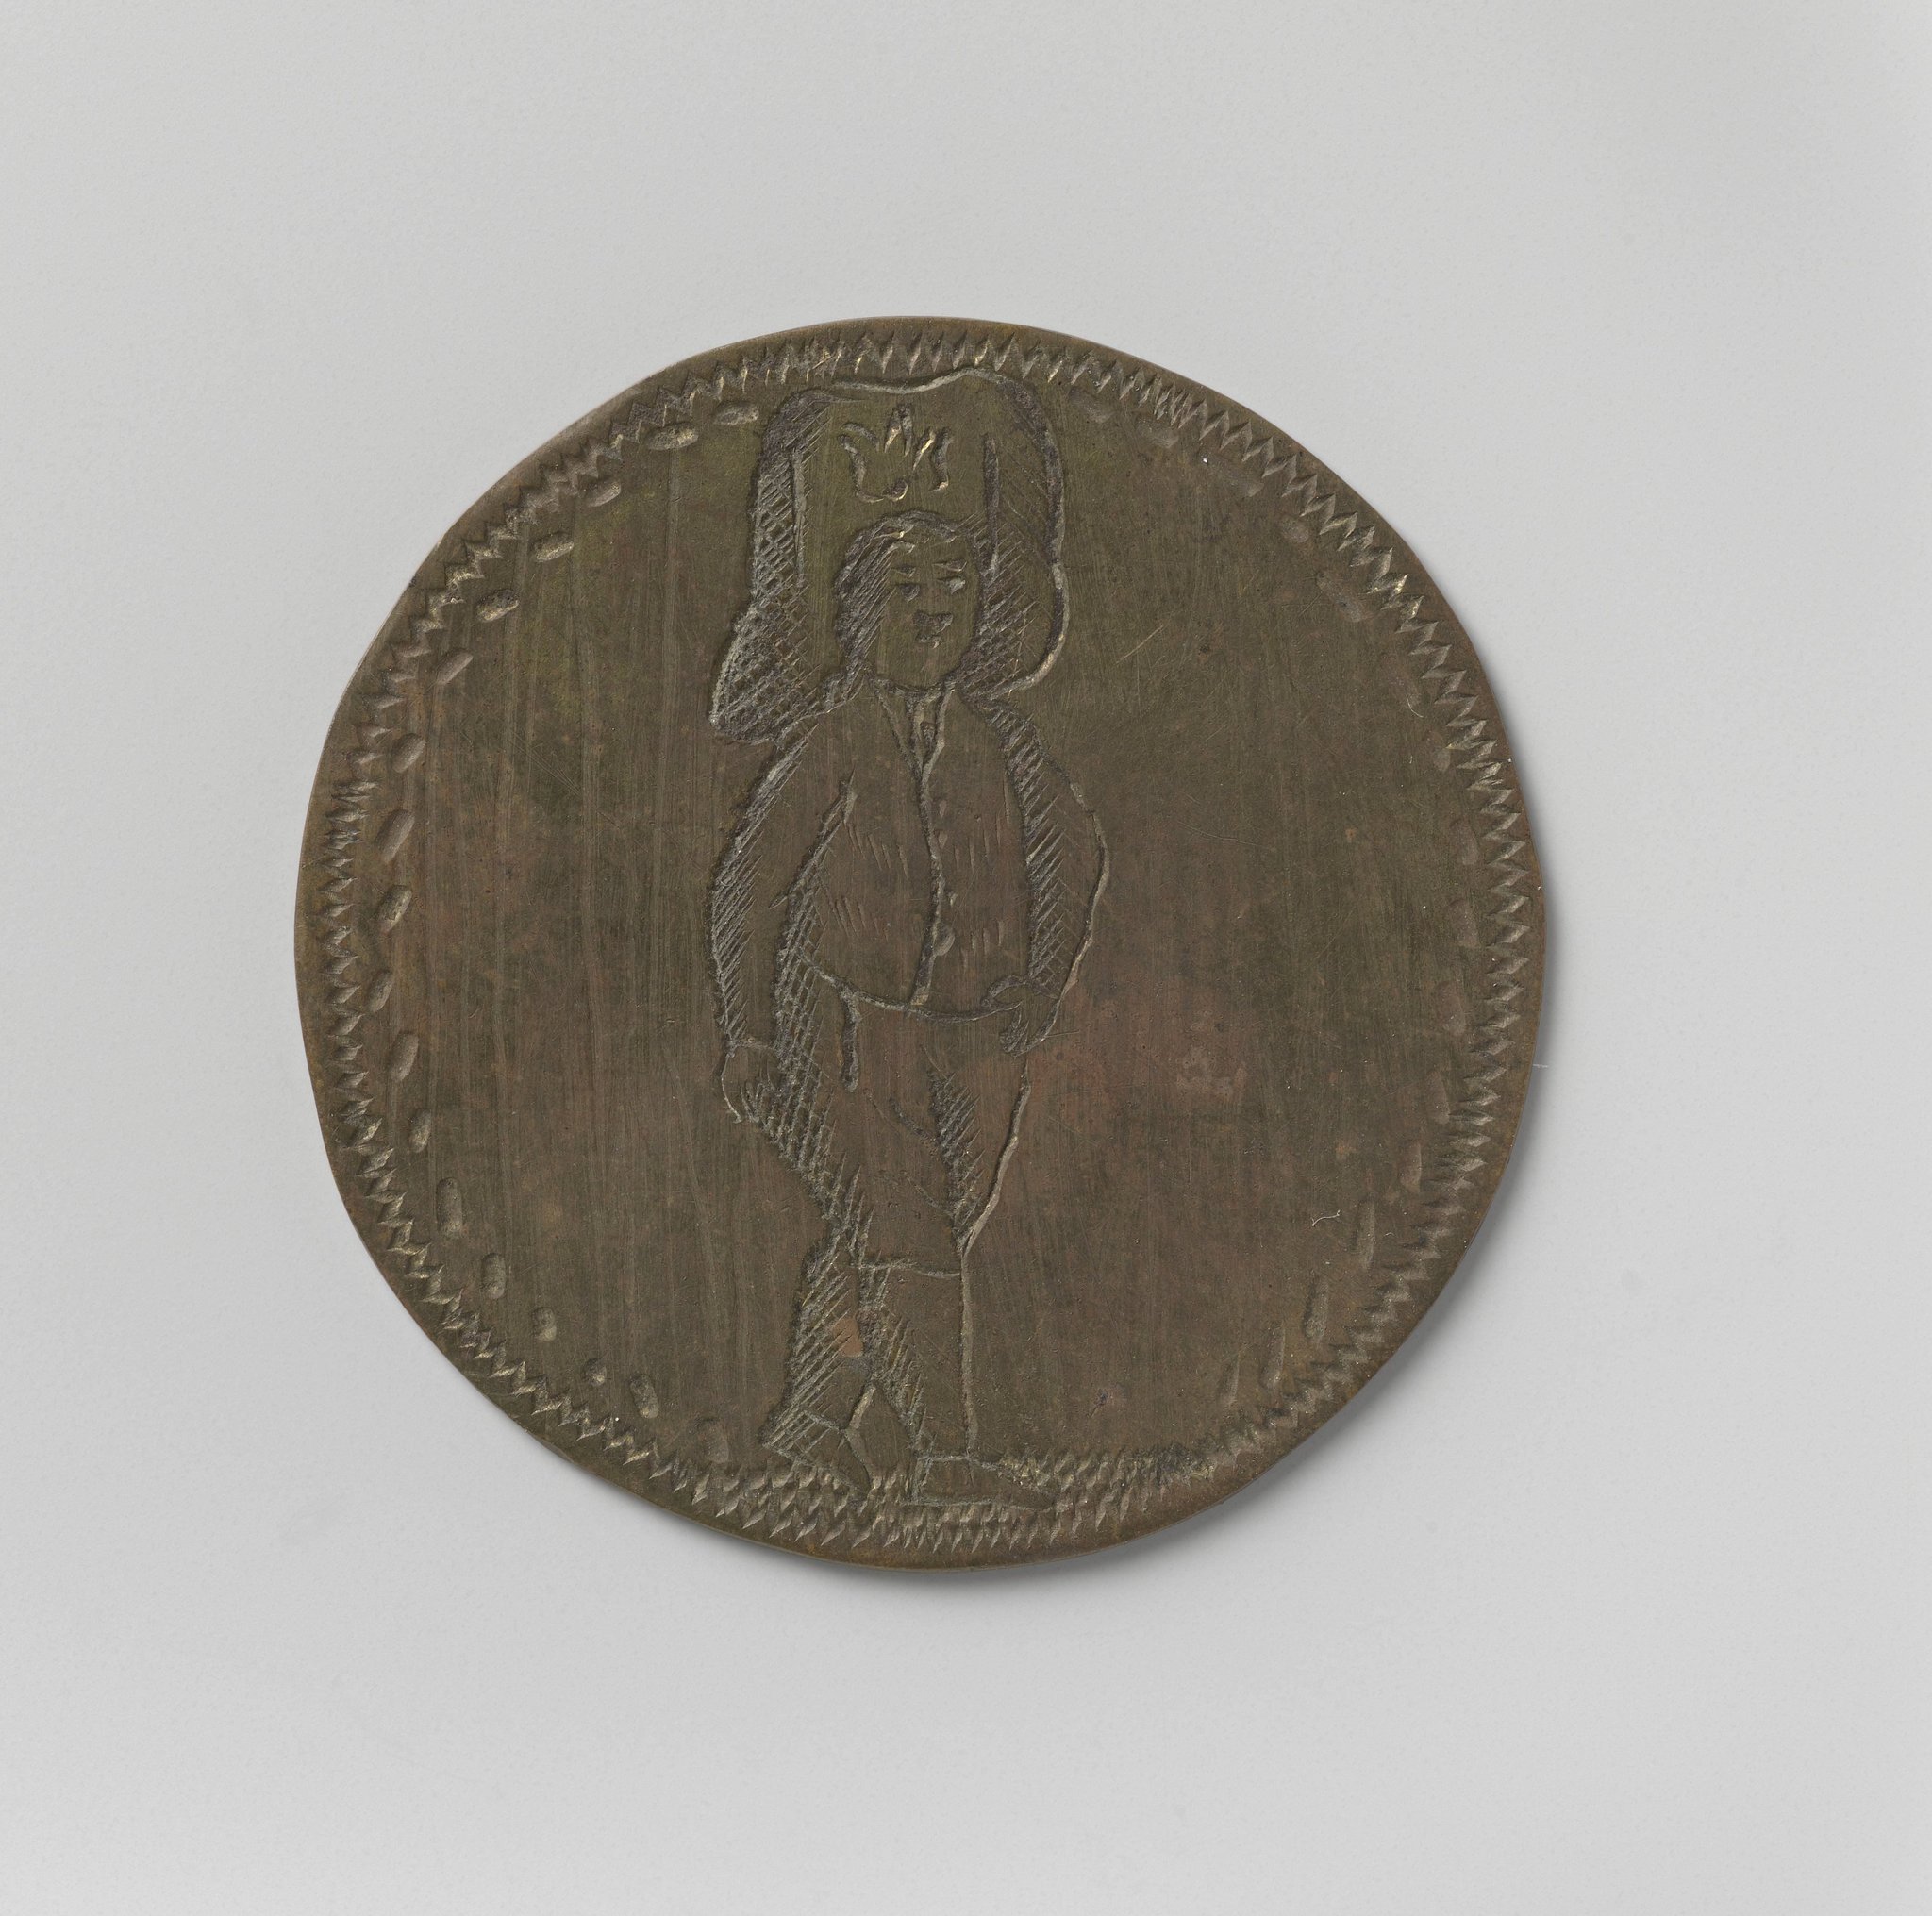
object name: medal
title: Korendragers- en -stortersgilde van Amsterdam, gildepenning van Jurrien Sigesmund Hilgendorff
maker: Anonymous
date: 1793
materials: brass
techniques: engraving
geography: amsterdam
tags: amsterdam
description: Messing penning. Voorzijde: lichtelijk naar rechts gewende man met last op hoofd binnen sierrand. Keerzijde: opschrift